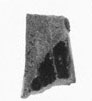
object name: shard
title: Shard (Study Collection)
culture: chinese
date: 1644-1911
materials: ceramic, glaze